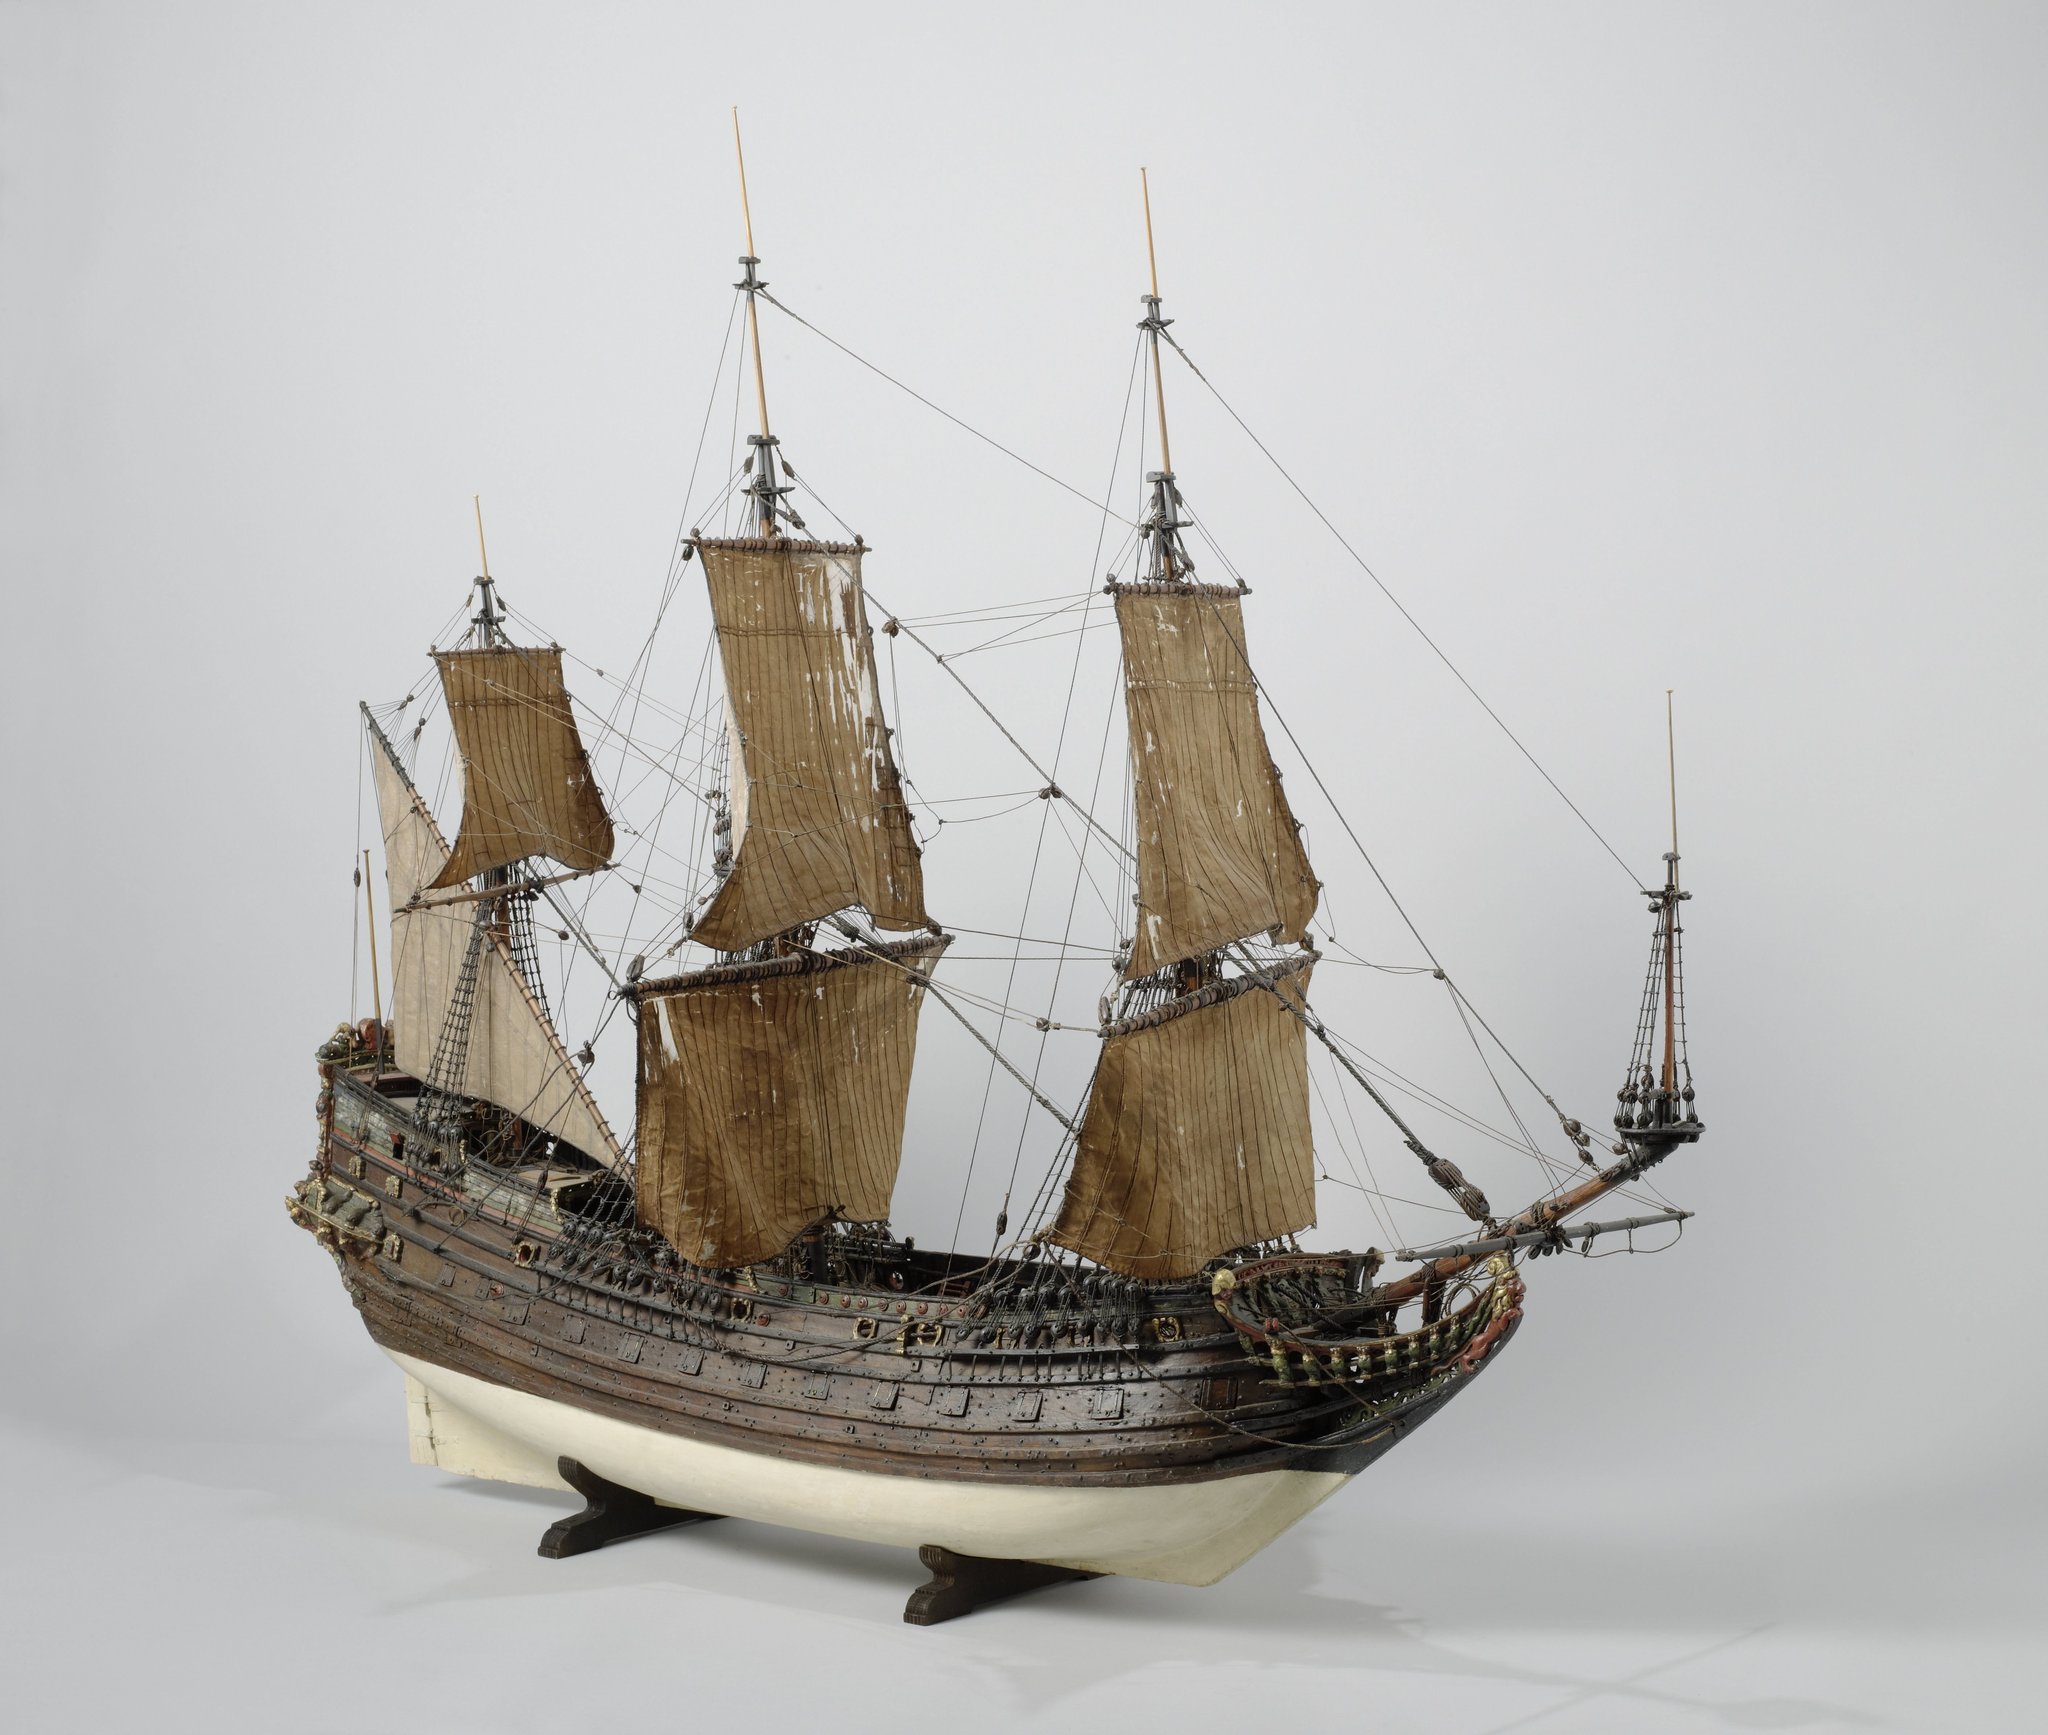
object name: ship model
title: Ship’s model of the Prins Willem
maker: Anonymous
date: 1651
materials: wood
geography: netherlands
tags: william ii (prince of orange), sailing-ship, sailing-boat, middelburg, europe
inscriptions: inscription: ‘VOC ZM’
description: The real Prins Willem left the harbour of Middelburg in 1651 for its maiden voyage to the East Indies. The ship sailed to Batavia (Jakarta) a total of five times before sinking – with no survivors – on its return home in 1662. The rudder is flanked by a city view of Middelburg, above which are the logo of the Dutch East India Company and a portrait of Prince William II.